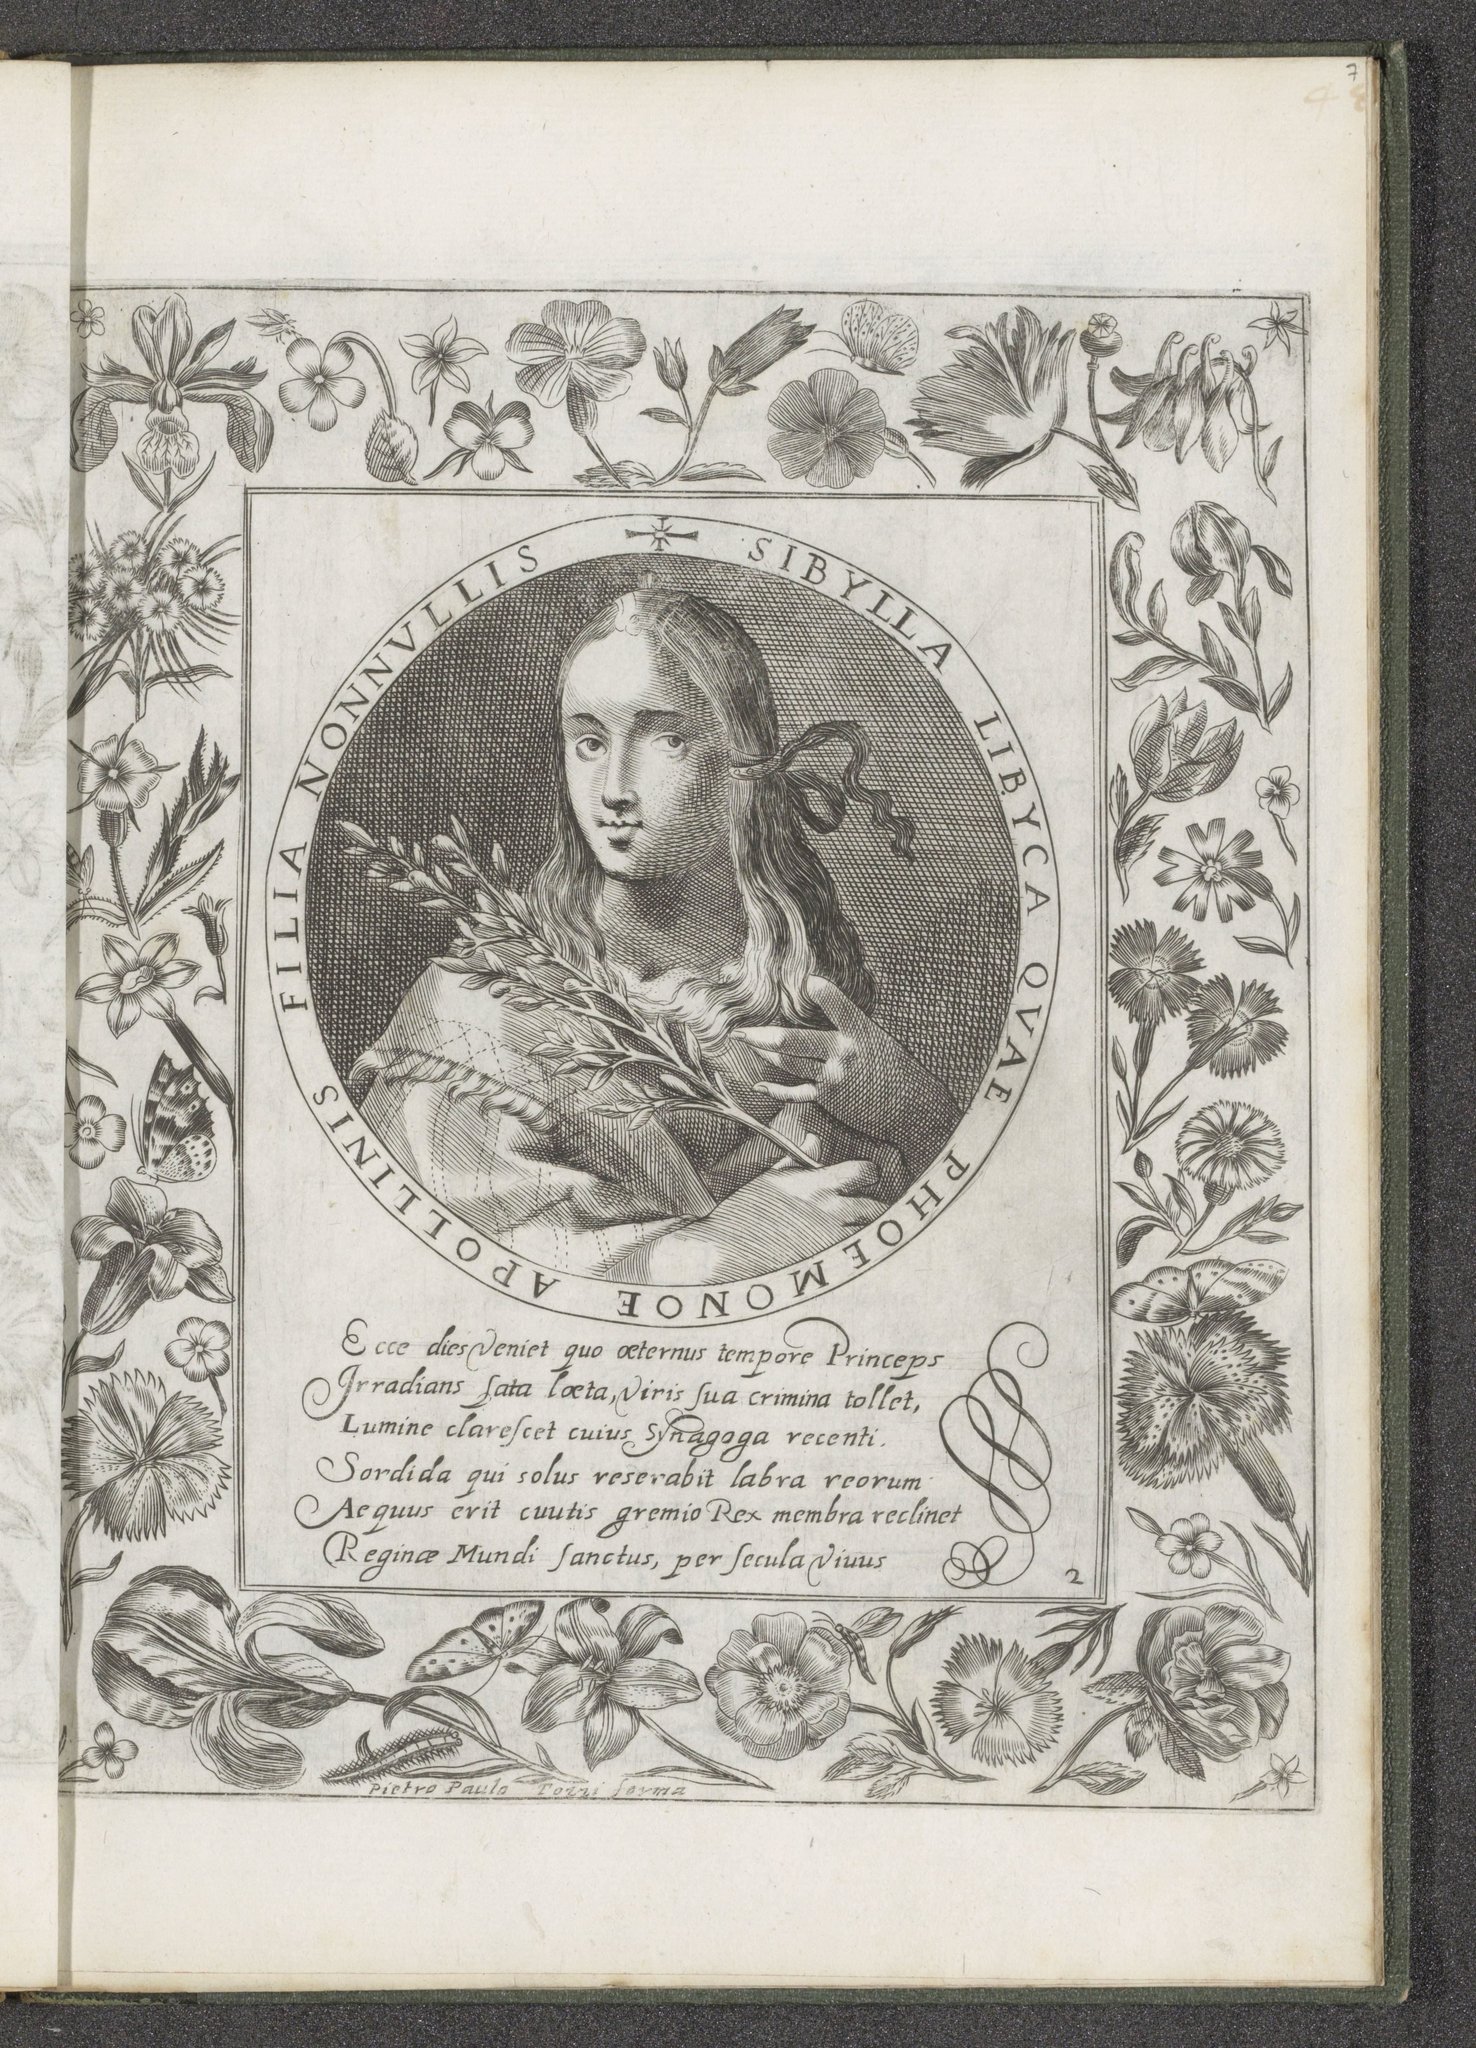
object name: print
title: Imagini Gentilissime delle dodici Sibille (...)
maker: pietro paolo tozzi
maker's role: print maker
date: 1601-1627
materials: paper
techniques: engraving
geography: padua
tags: flowers, sibyls (with name)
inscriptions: number: ‘48’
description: Buste van de Libische Sibille. In haar rechterhand houdt ze een olijftak. De voorstelling is gevat in een medaillon met een randschrift in het Latijn. Onder de voorstelling een zesregelig onderschrift in het Latijn. Rondom een kader met bloemen, onder andere een iris en akelei. Prent maakt deel uit van een album.